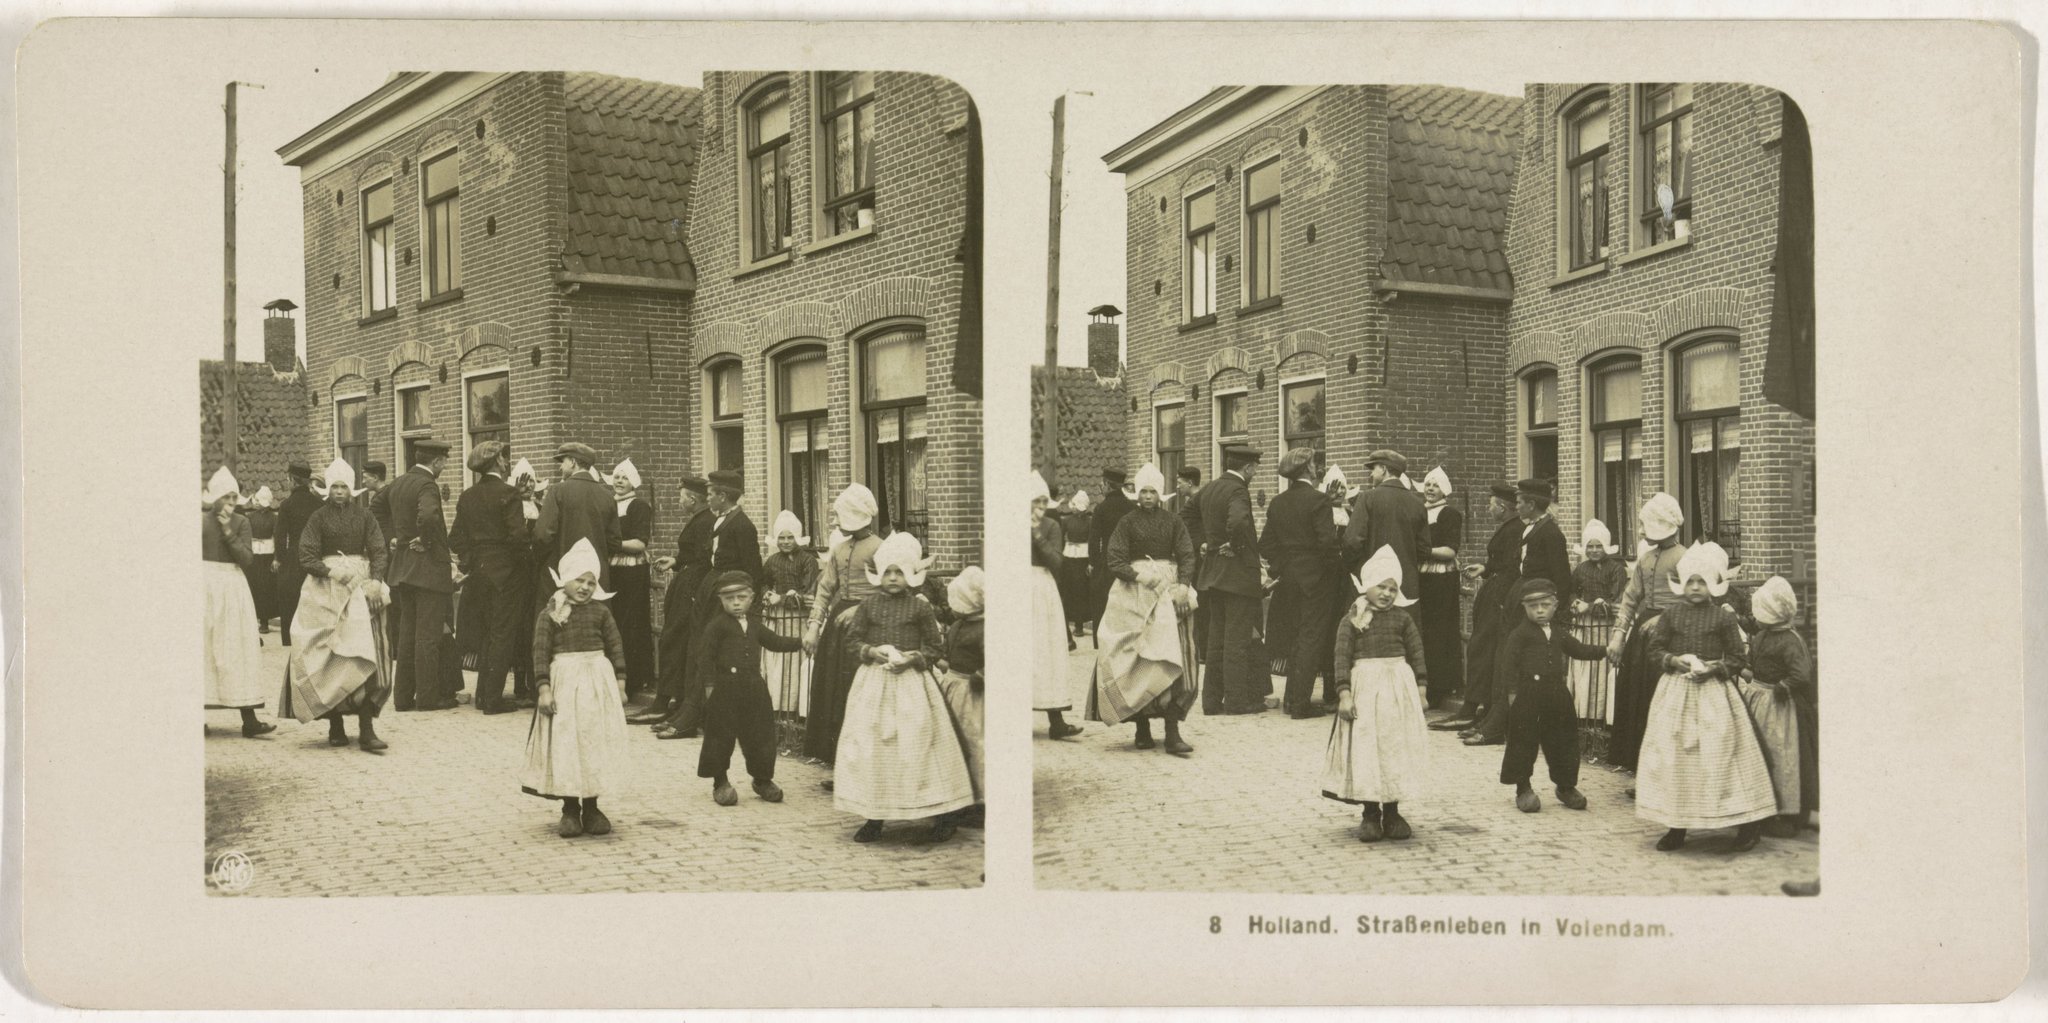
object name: stereograph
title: 8 Holland. Straßenleben in Volendam.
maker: ngp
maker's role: fotograaf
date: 1900-1940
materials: cardboard, paper, photographic support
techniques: gelatin silver print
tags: volendam